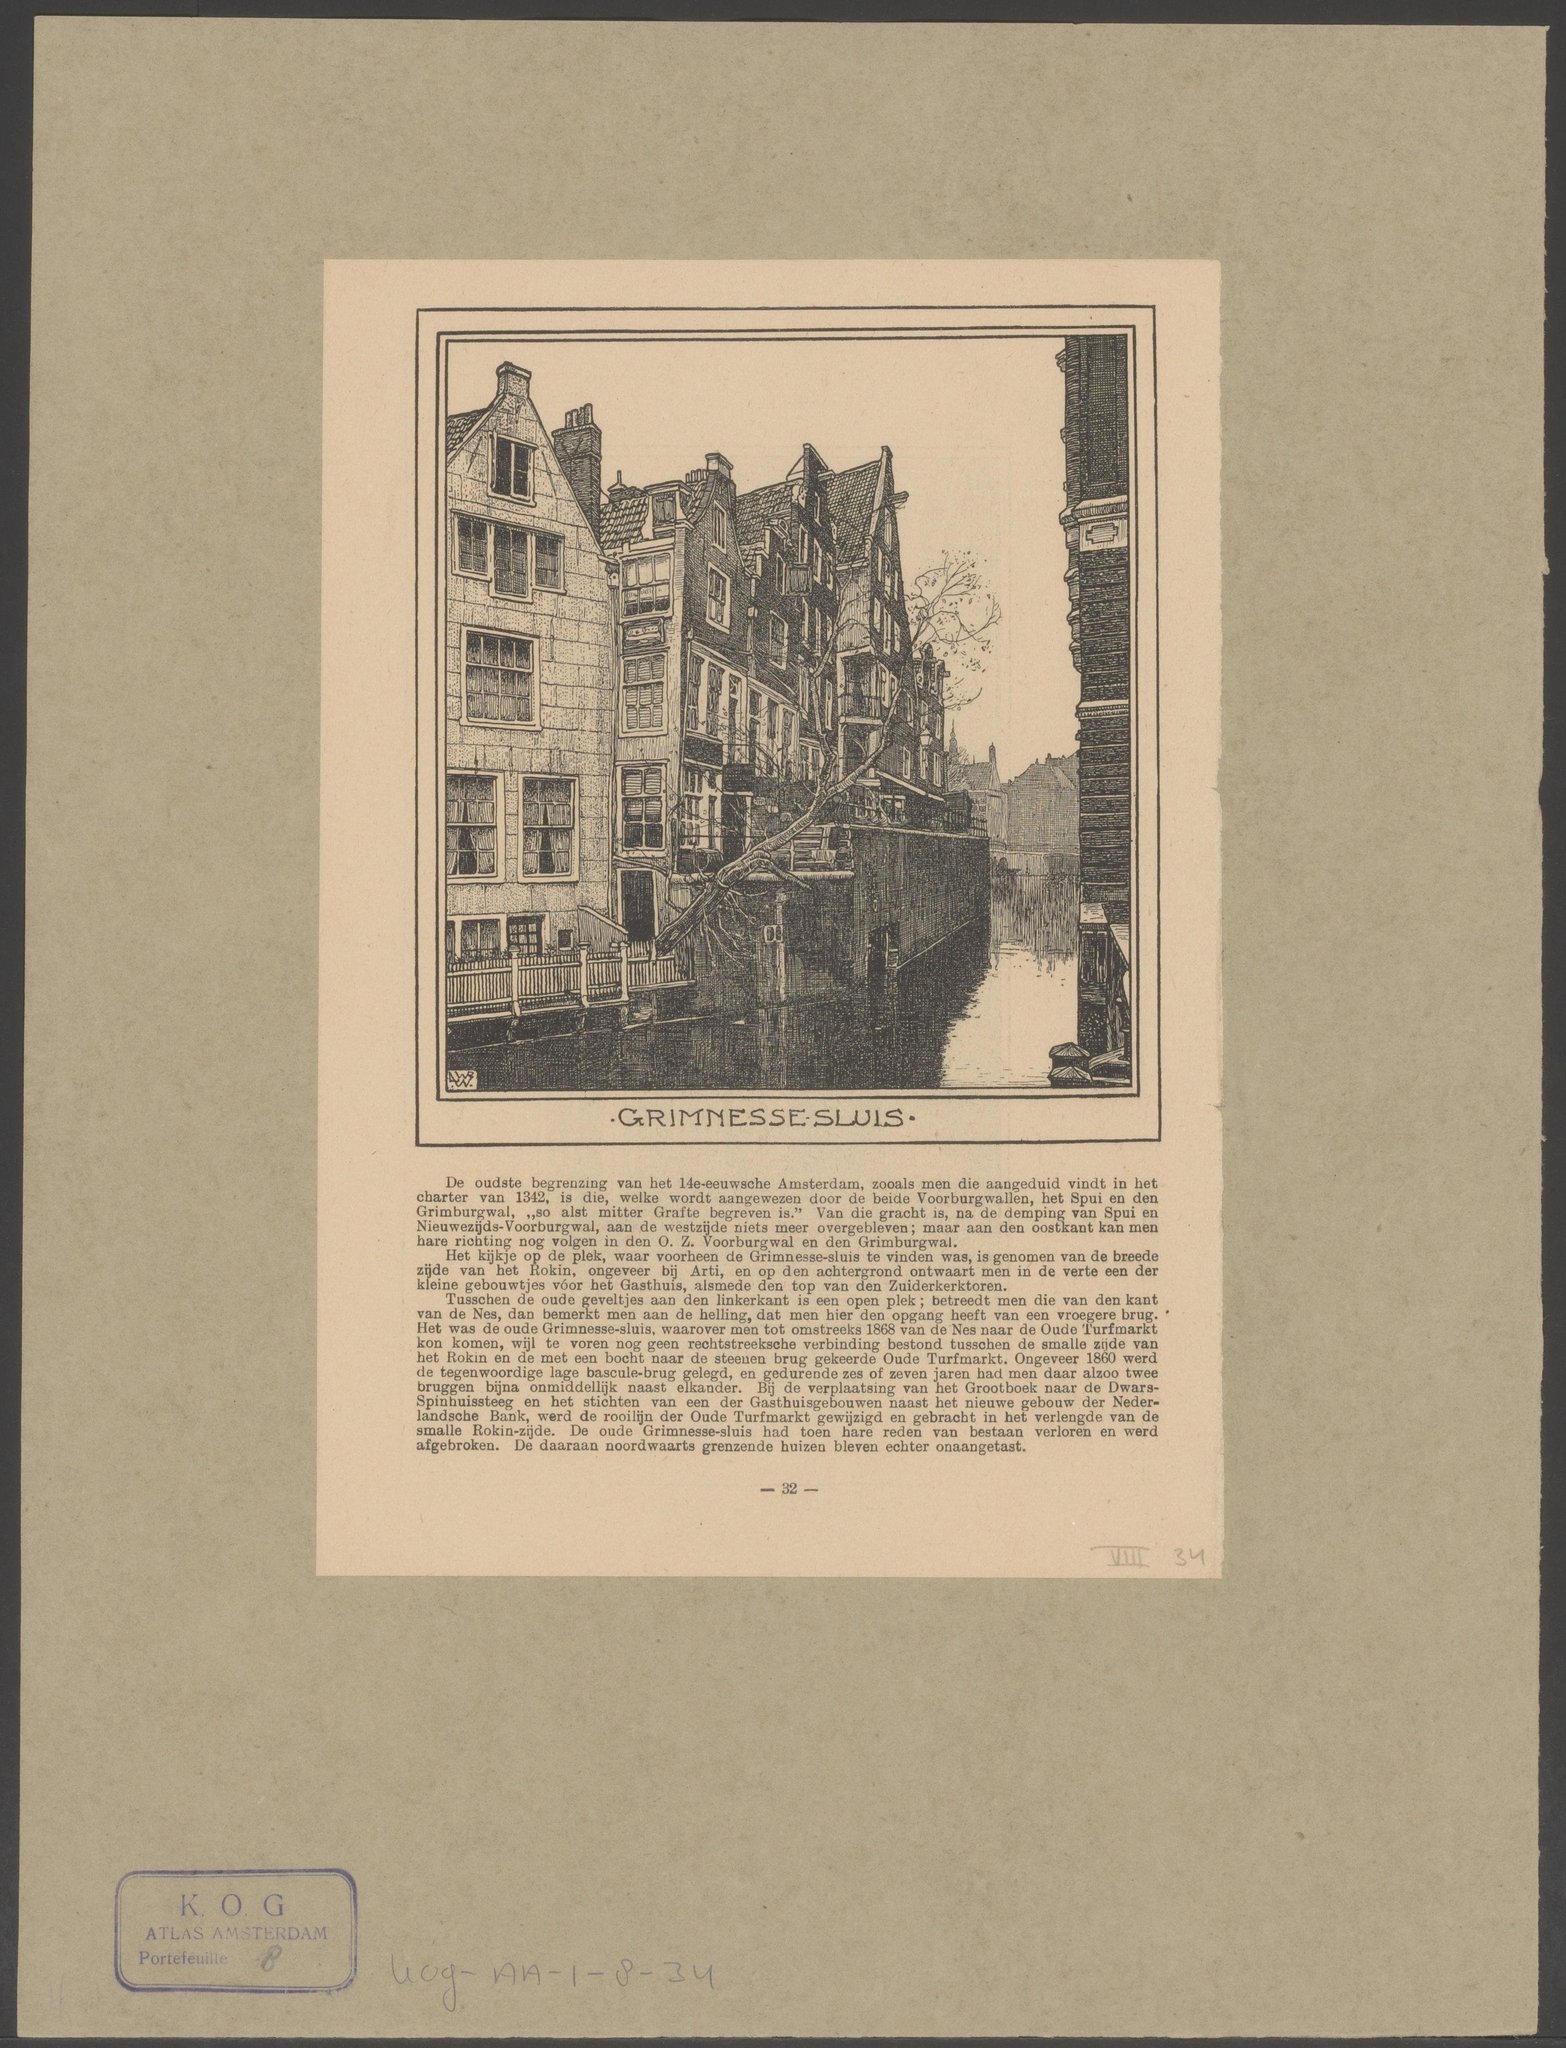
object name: photomechanical print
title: Gezicht op de Grimnessesluis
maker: willem wenckebach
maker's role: designer, draughtsman, painter, print maker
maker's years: 1860-1937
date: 1870-1923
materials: paper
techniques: letterpress printing, line block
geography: amsterdam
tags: city-view in general; 'veduta', canal, the usual house or row of houses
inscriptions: collector's mark: ‘8’ Lugt 1641b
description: Onderwerpsrubriek binnen de Atlas Amsterdam: Galerij Paleis voor Volksvlijt, Gebed zonder end, Geldersche Kade, Gravenstraat, Grimburgwal, Grimnessesluis, Groeneburgwal.